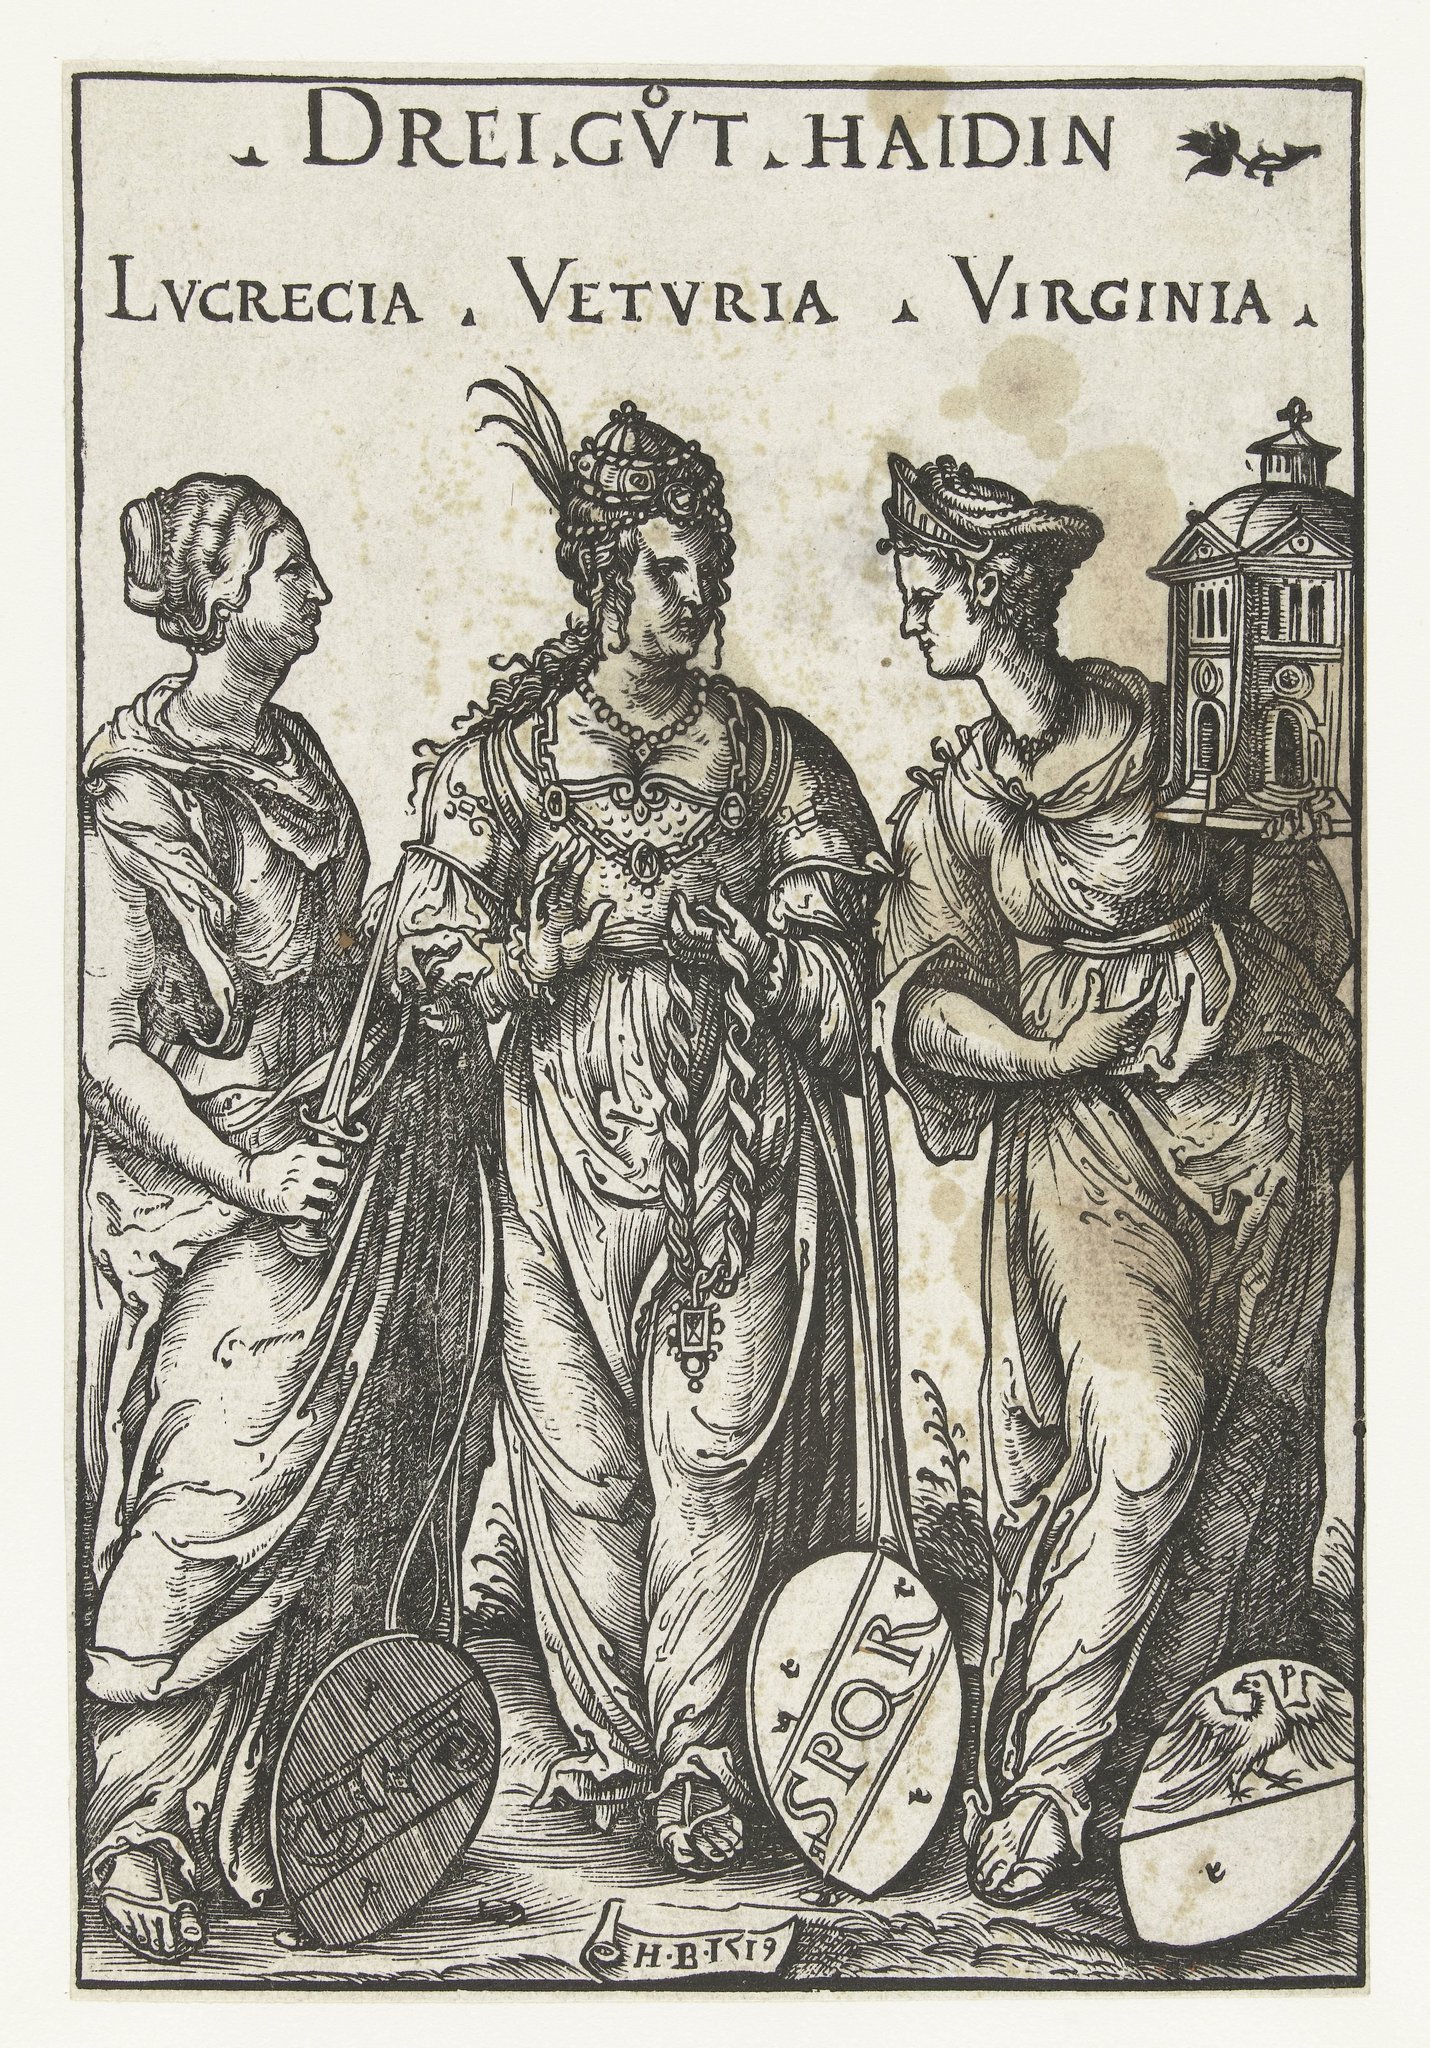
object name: print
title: Drei güt Haidin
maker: hans burgkmair (i)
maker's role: draughtsman, print maker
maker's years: 1473-1531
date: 1519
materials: paper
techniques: woodcut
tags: virginia (one of the nine worthiest women), veturia, mother of coriolanus (one of the nine worthiest women), lucretia (one of the nine worthiest women)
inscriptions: collector's mark: Lugt 240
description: De heilige Lucretia staat links met een zwaard, Veturia staat in het midden en houdt een keten vast en rechts staat Virginia met een kerkmodel in haar hand. Op de grond staan drie schilden met wapens van de vrouwen. De Duitse tekst verwijst naar hun plaats in de serie helden en heldinnen, zij stellen de drie heidense vrouwen uit de Romeinse geschiedenis voor.